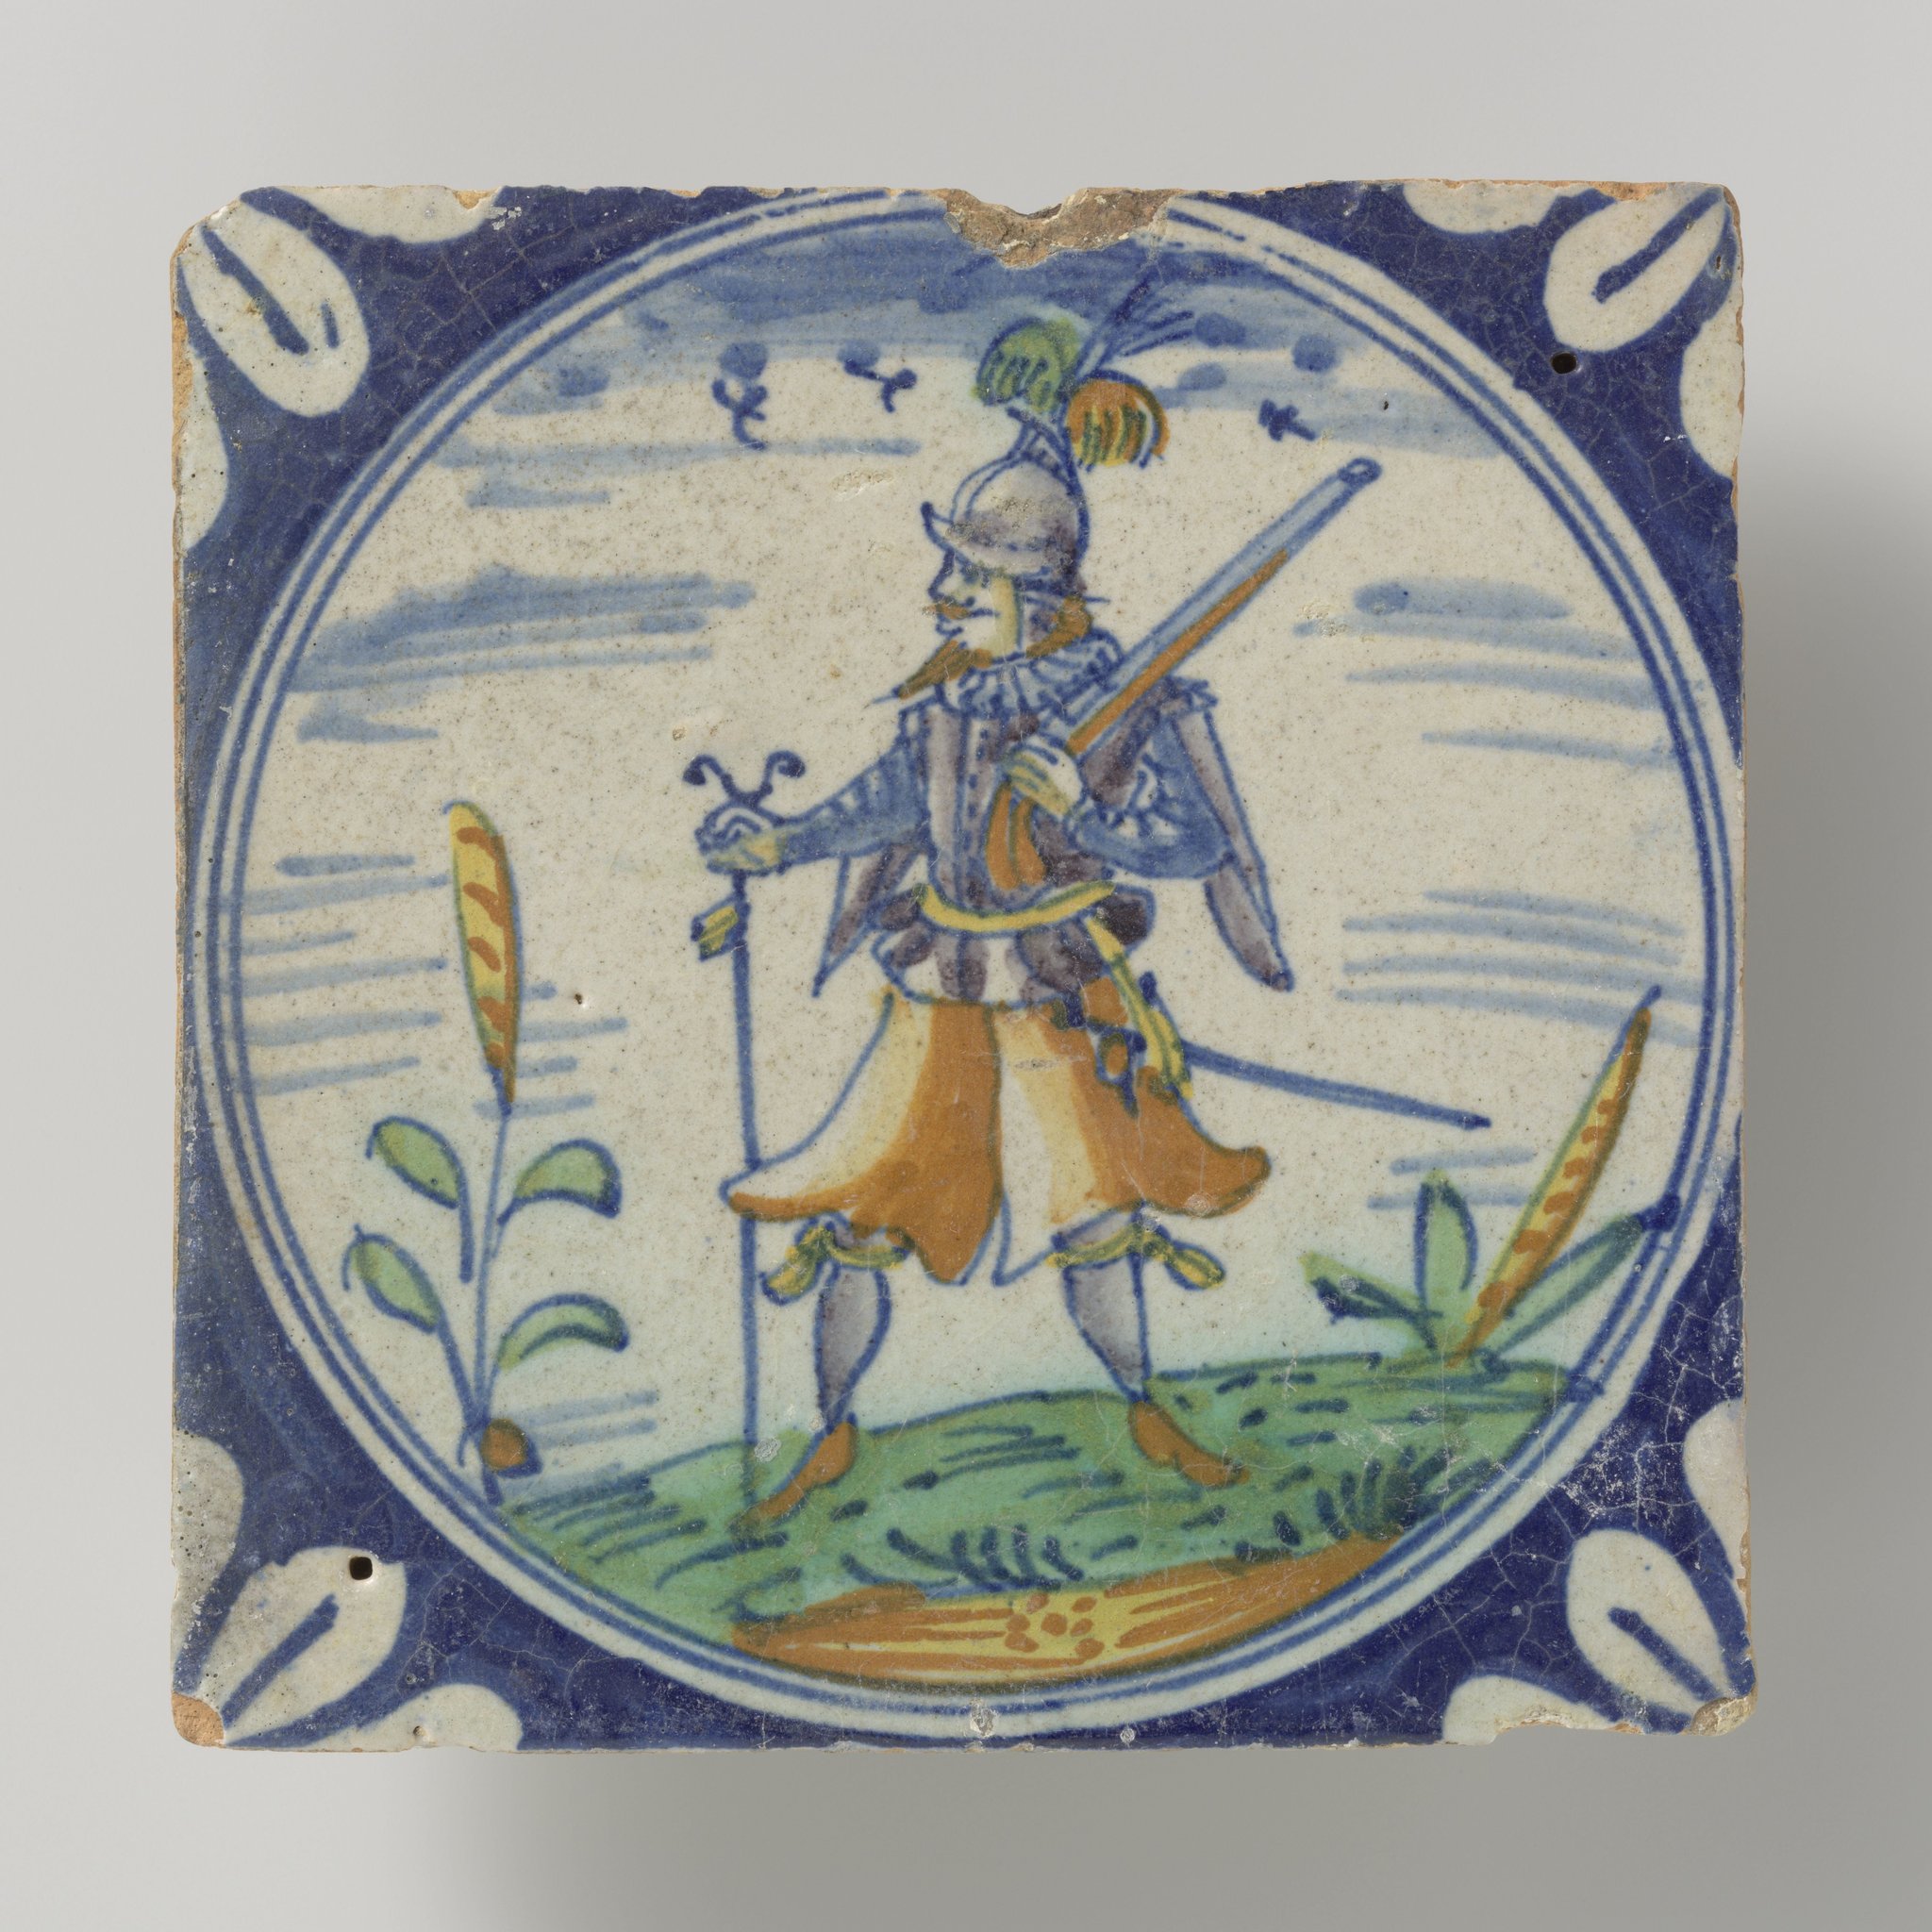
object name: tile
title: Tegel, veelkleurig beschilderd met een soldaat of een vaandeldrager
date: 1625-1700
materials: earthenware, glaze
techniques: maiolica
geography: netherlands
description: Tegel, veelkleurig beschilderd met een soldaat of een vaandeldrager.